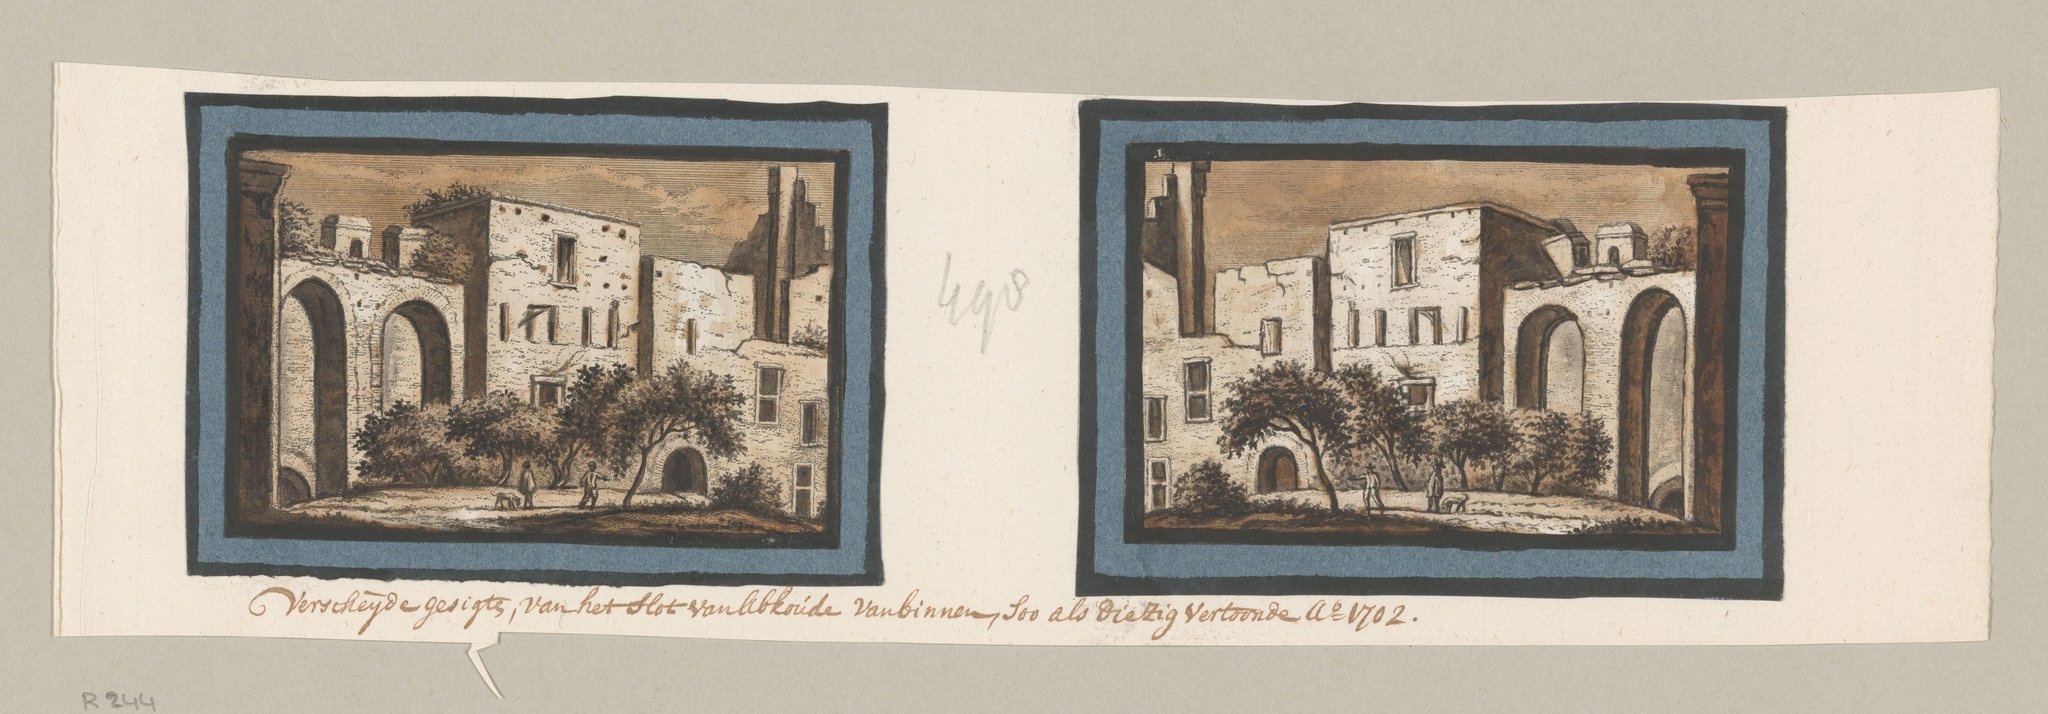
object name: book illustration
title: Gezichten op het binnenplein van Slot Abcoude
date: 1725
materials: ink, paper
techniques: brush, etching, hand coloring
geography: amsterdam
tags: castle, landscape with tower or castle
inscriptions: annotation: ‘"Verscheijde gesigten, van het slot van Abkoude van binnen, zoo als die zig vertoonde Ao. 1702."’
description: Op een oud opzetvel, met daarop een handgeschreven beschrijving van het afgebeelde object, links een ingekleurd exemplaar van de prent zoals die voorkomt als nr. 244 in: Rademaker, Abraham. Kabinet van Nederlandsche outheden en gezichten (...). Amsterdam: Willem Barents, 1725. Rechts op het opzetvel een spiegelbeeldige kopie van diezelfde prent, tevens ingekleurd.